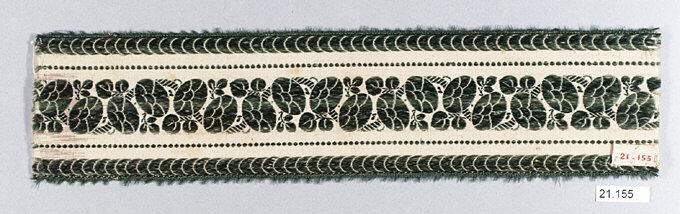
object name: ribbon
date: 1830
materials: cotton, linen, silk